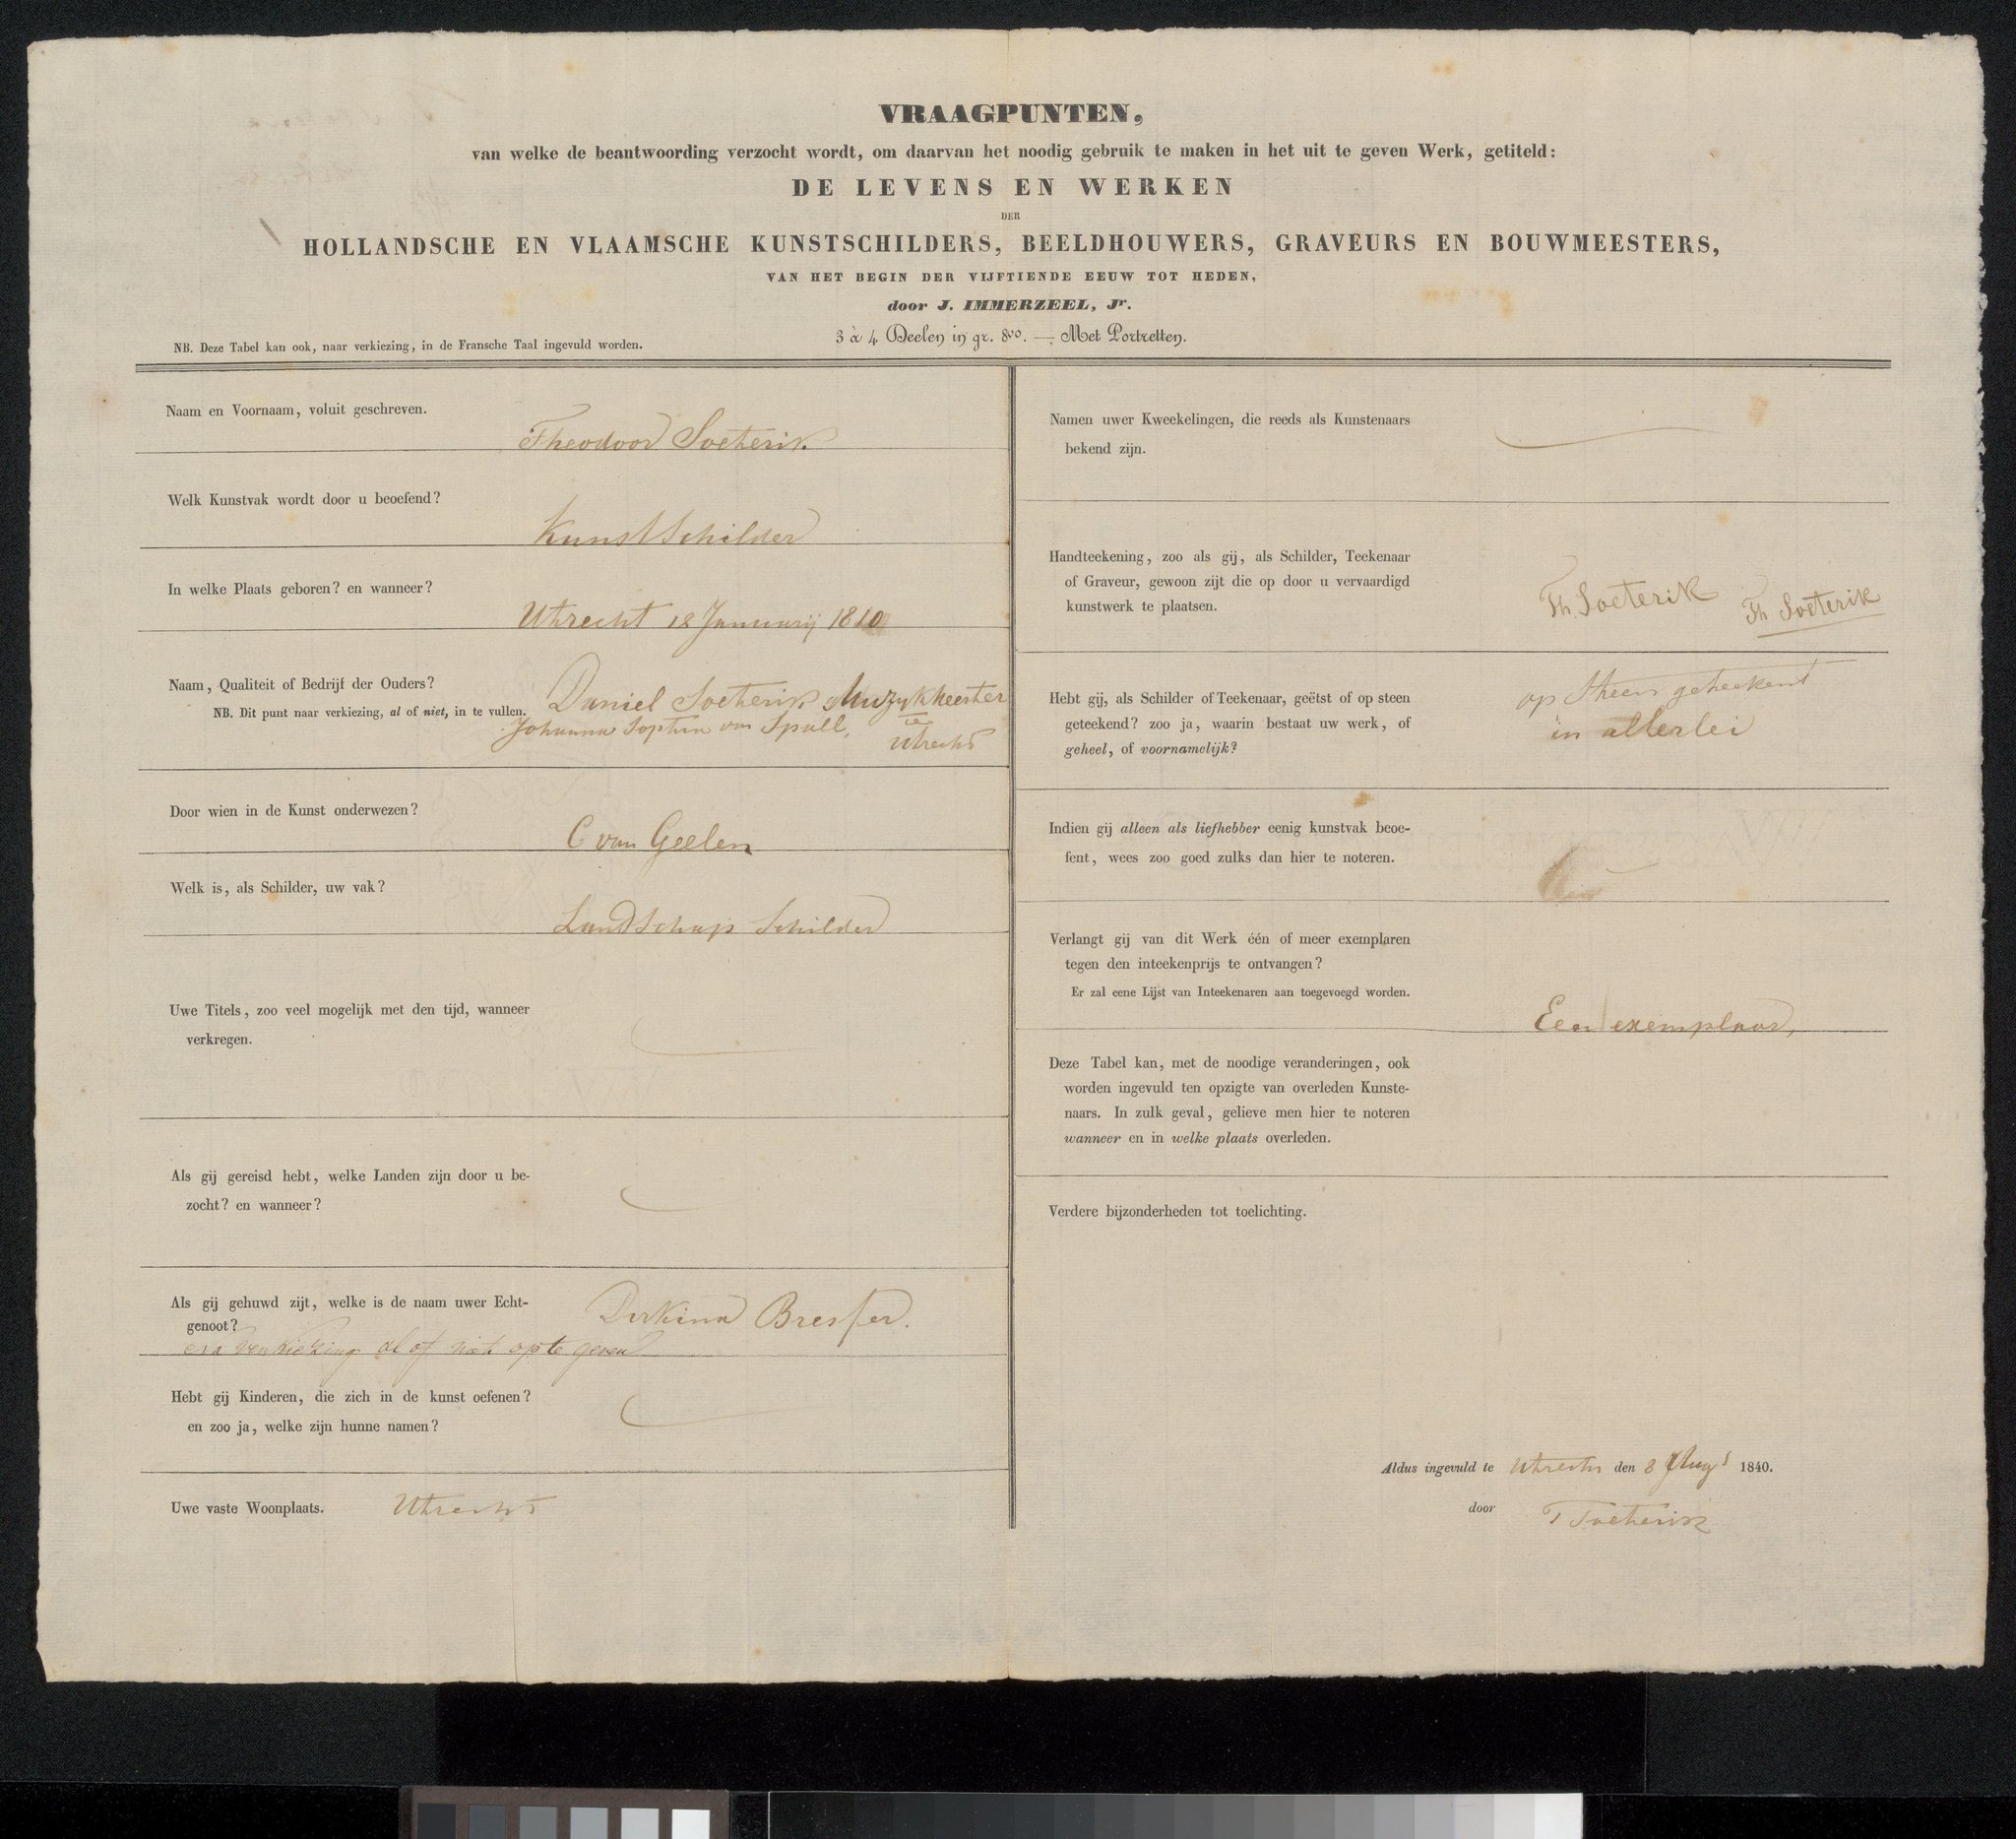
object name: questionnaire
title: Enquêteformulier ingevuld door Theodoor Soeterik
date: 1840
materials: ink, paper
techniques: pen, printing, writing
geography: utrecht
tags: utrecht, draughtsman, theodoor soeterik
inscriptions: inscription: ‘Vraagpunten,/ van welke de beantwoording verzocht wordt, om daarvan het noodig gebruik te maken in het uit te geven Werk, getiteld: De levens en werken/ der Hollandsche en Vlaamsche kunstschilders, beeldhouwers,/ graveurs en bouwmeesters, van het begin der vijftiende eeuw tot heden/ door J. Immerzeel, Jr.’, watermark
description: Opgenomen in: Immerzeel, J. Jr., De levens en werken der Hollandsche en Vlaamsche kunstschilders, beeldhouwers, graveurs en bouwmeesters, van het begin der vijftiende eeuw tot heden, Amsterdam: J.C. van Kesteren, 1842-1843.